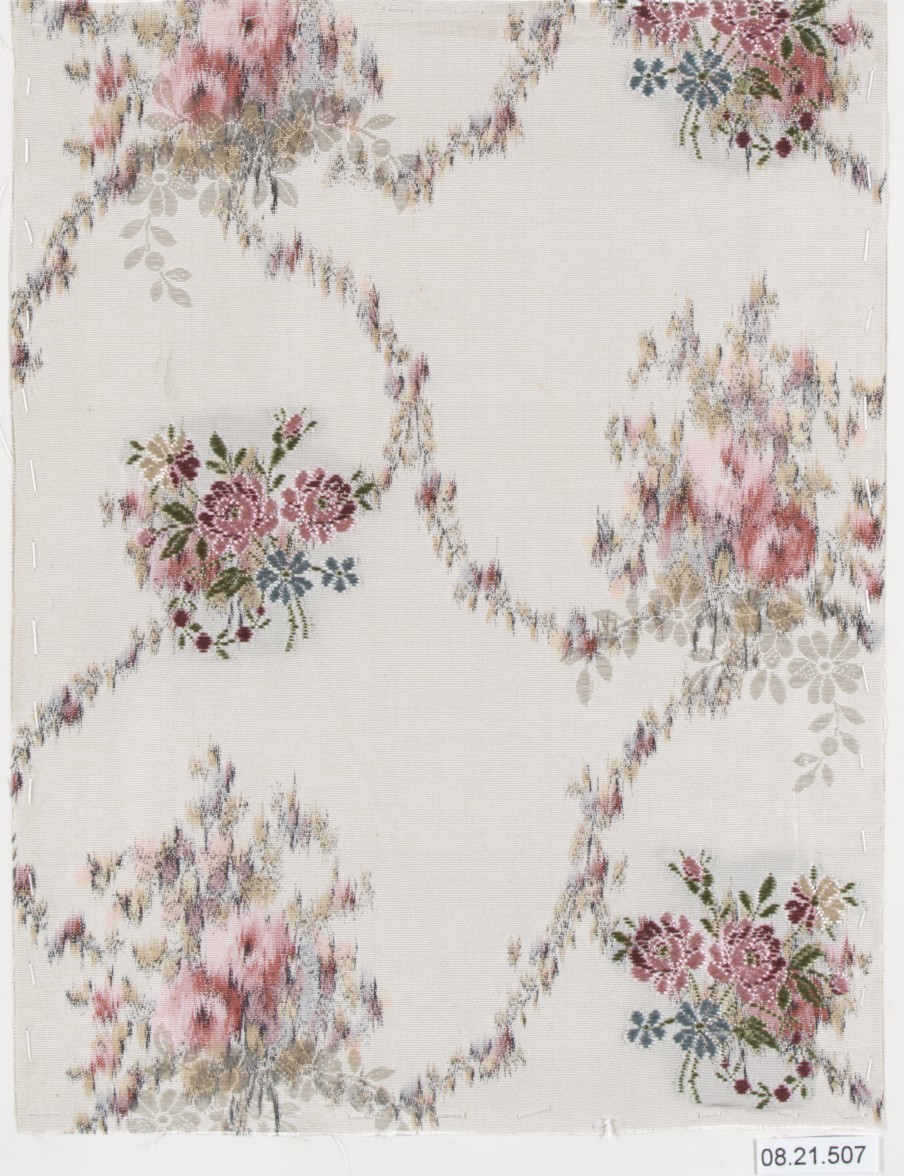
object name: textile sample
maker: Anonymous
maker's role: designer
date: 1900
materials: silk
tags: flowers